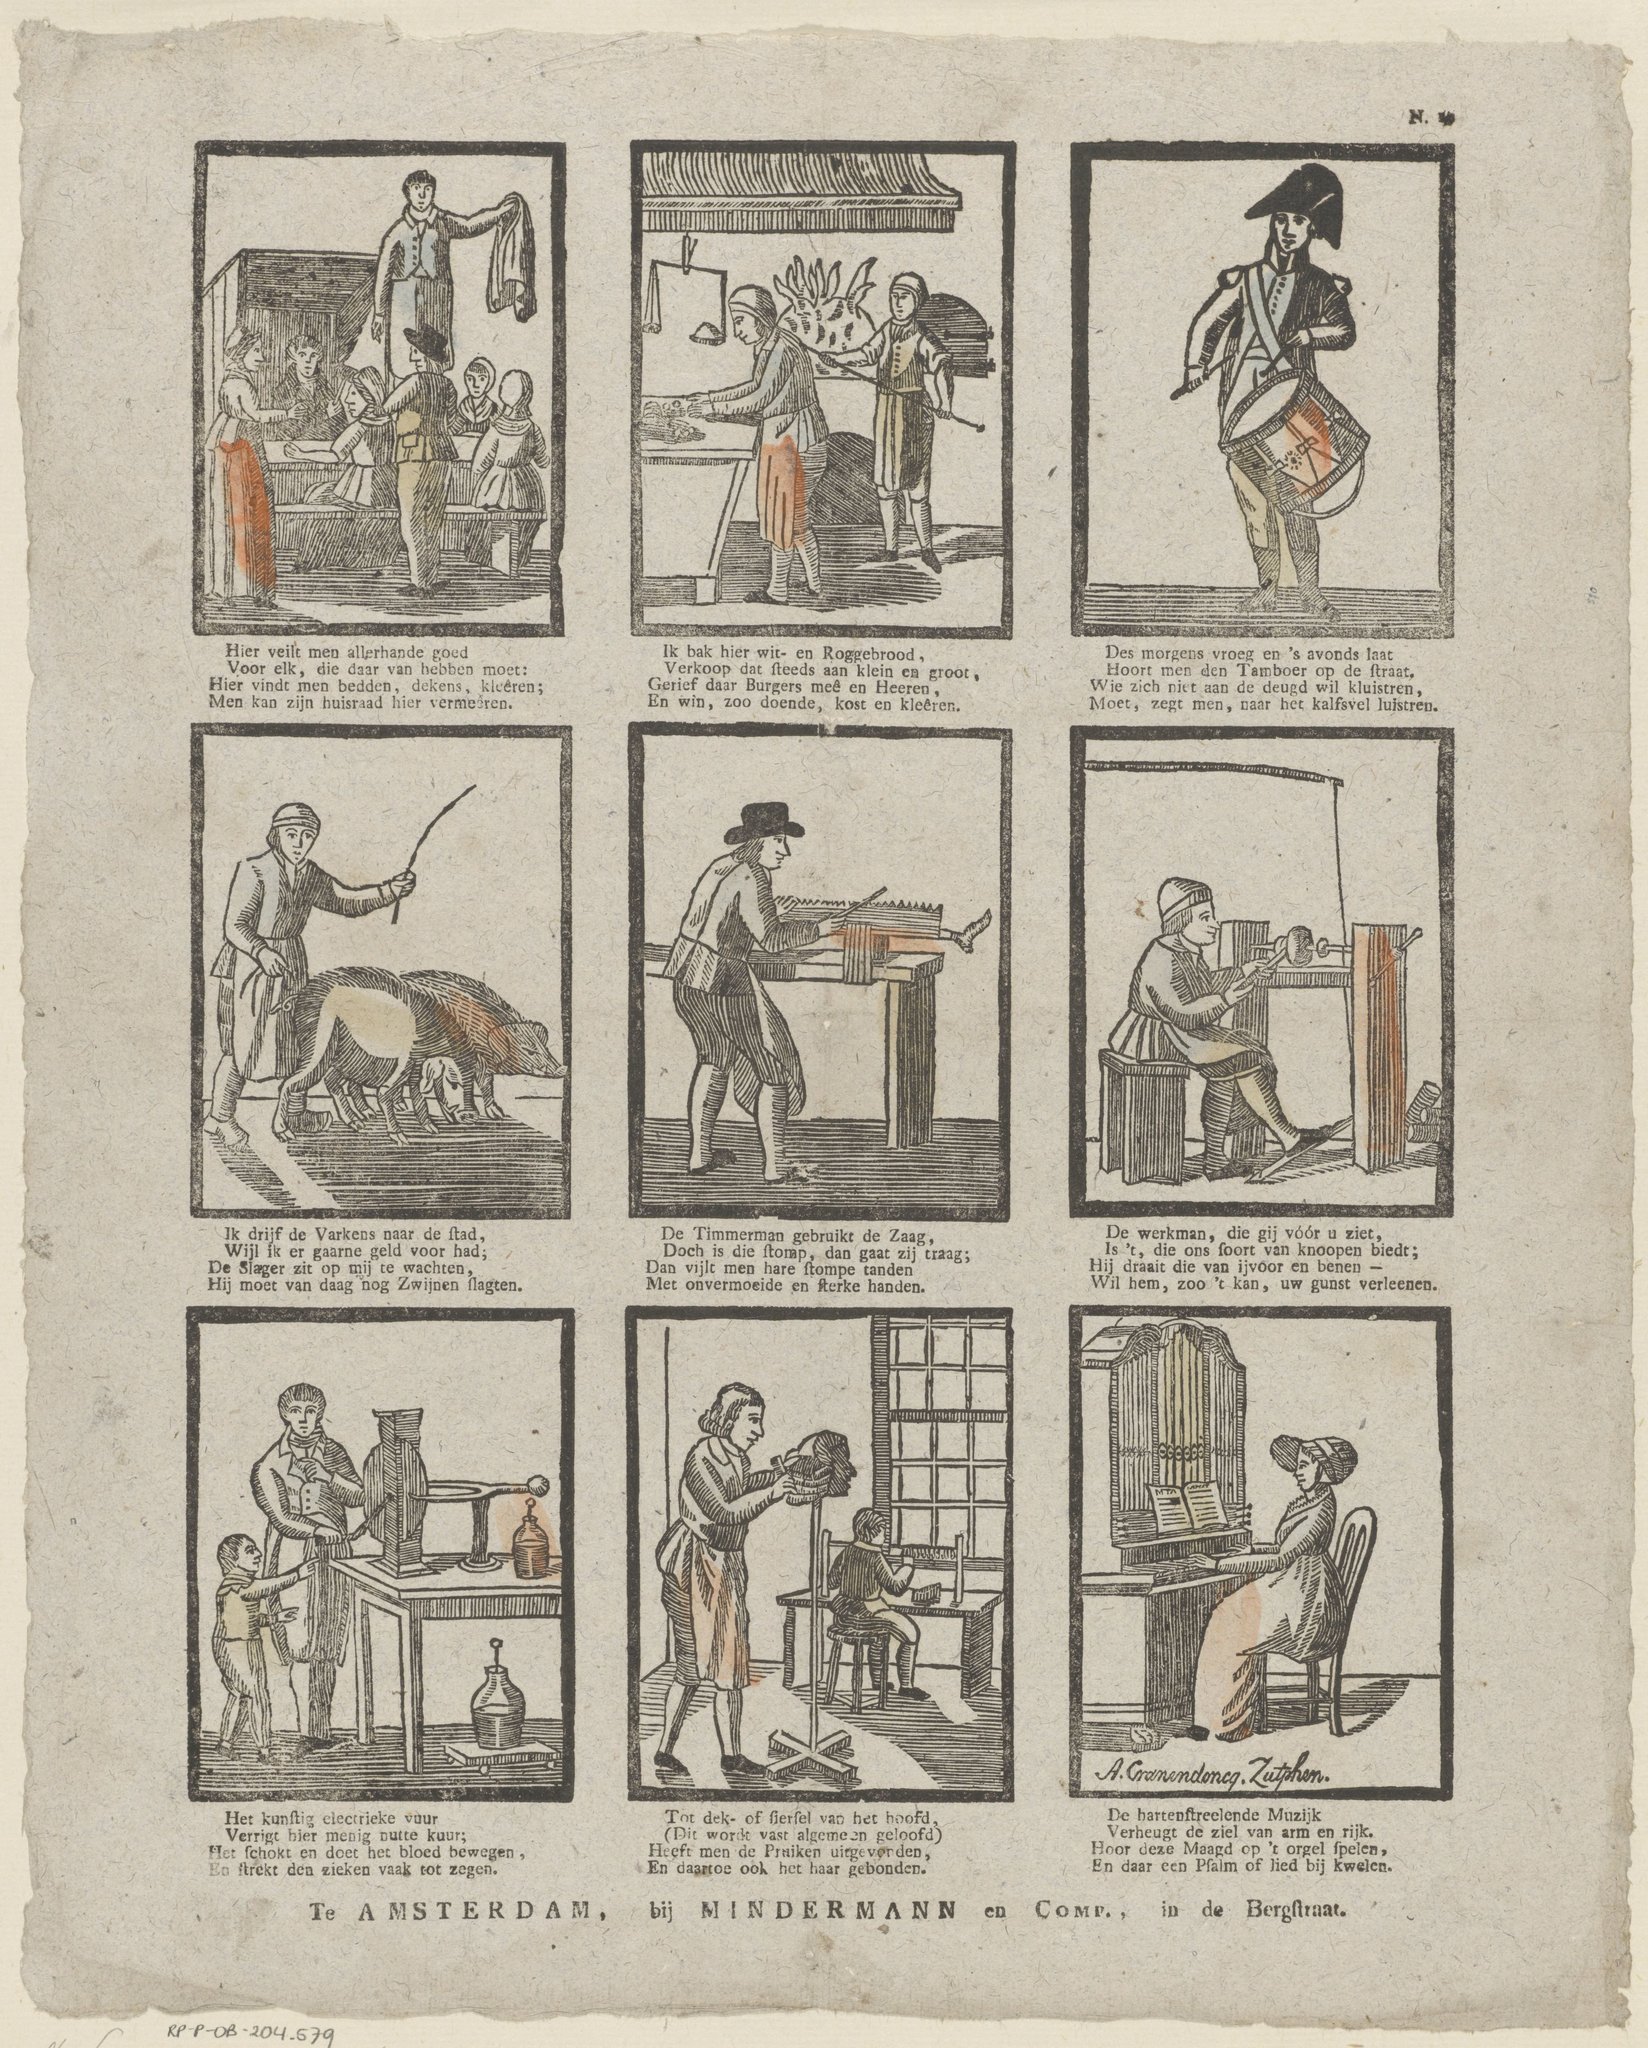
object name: print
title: Beroepen en ambachten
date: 1822-1849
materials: paper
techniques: colour, letterpress printing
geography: zutphen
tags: wigmaker, 'perruquier', craft-production, skilled handiwork, farmers, working class, labourers, street-trader, crafts and industries, merchant, salesman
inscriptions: collector's mark: Lugt 2760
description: Blad met 9 voorstellingen van ambachtslieden en beroepen, zoals straatverkoper, tamboer, timmerman en pruikenmaker. Onder elke afbeelding een vierregelig vers. Genummerd rechtsboven: N. 17.